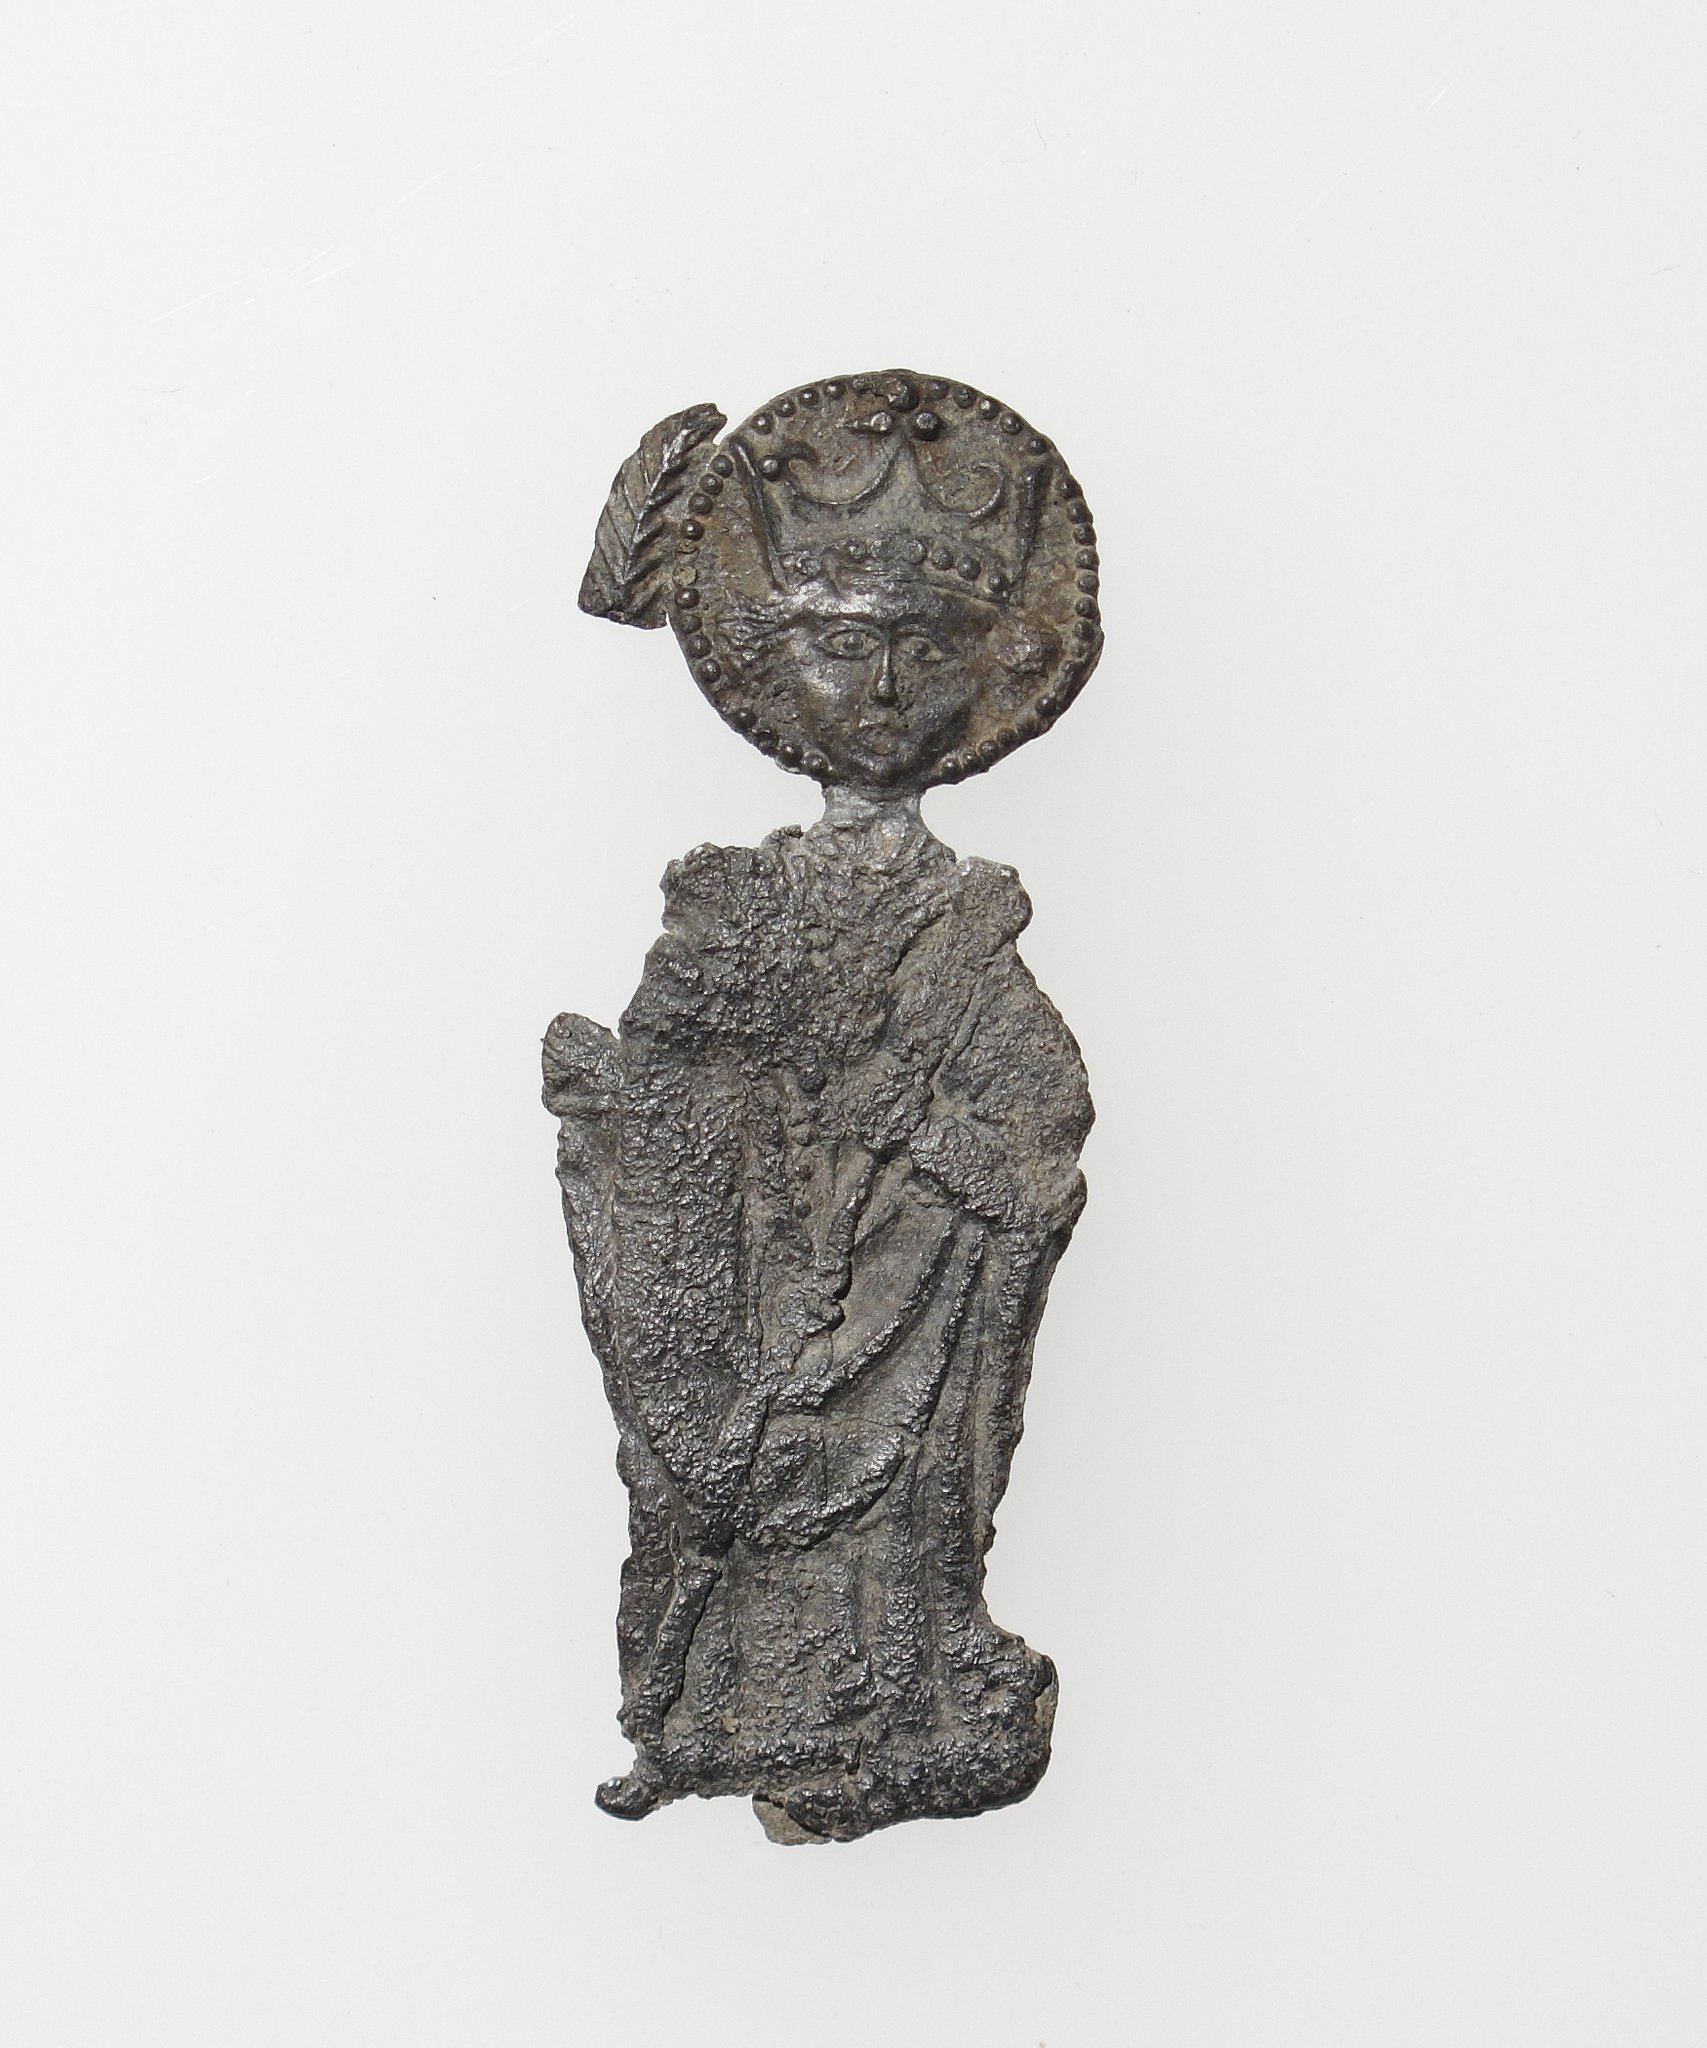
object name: pilgrim's badge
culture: french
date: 1301-1600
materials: lead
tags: saints